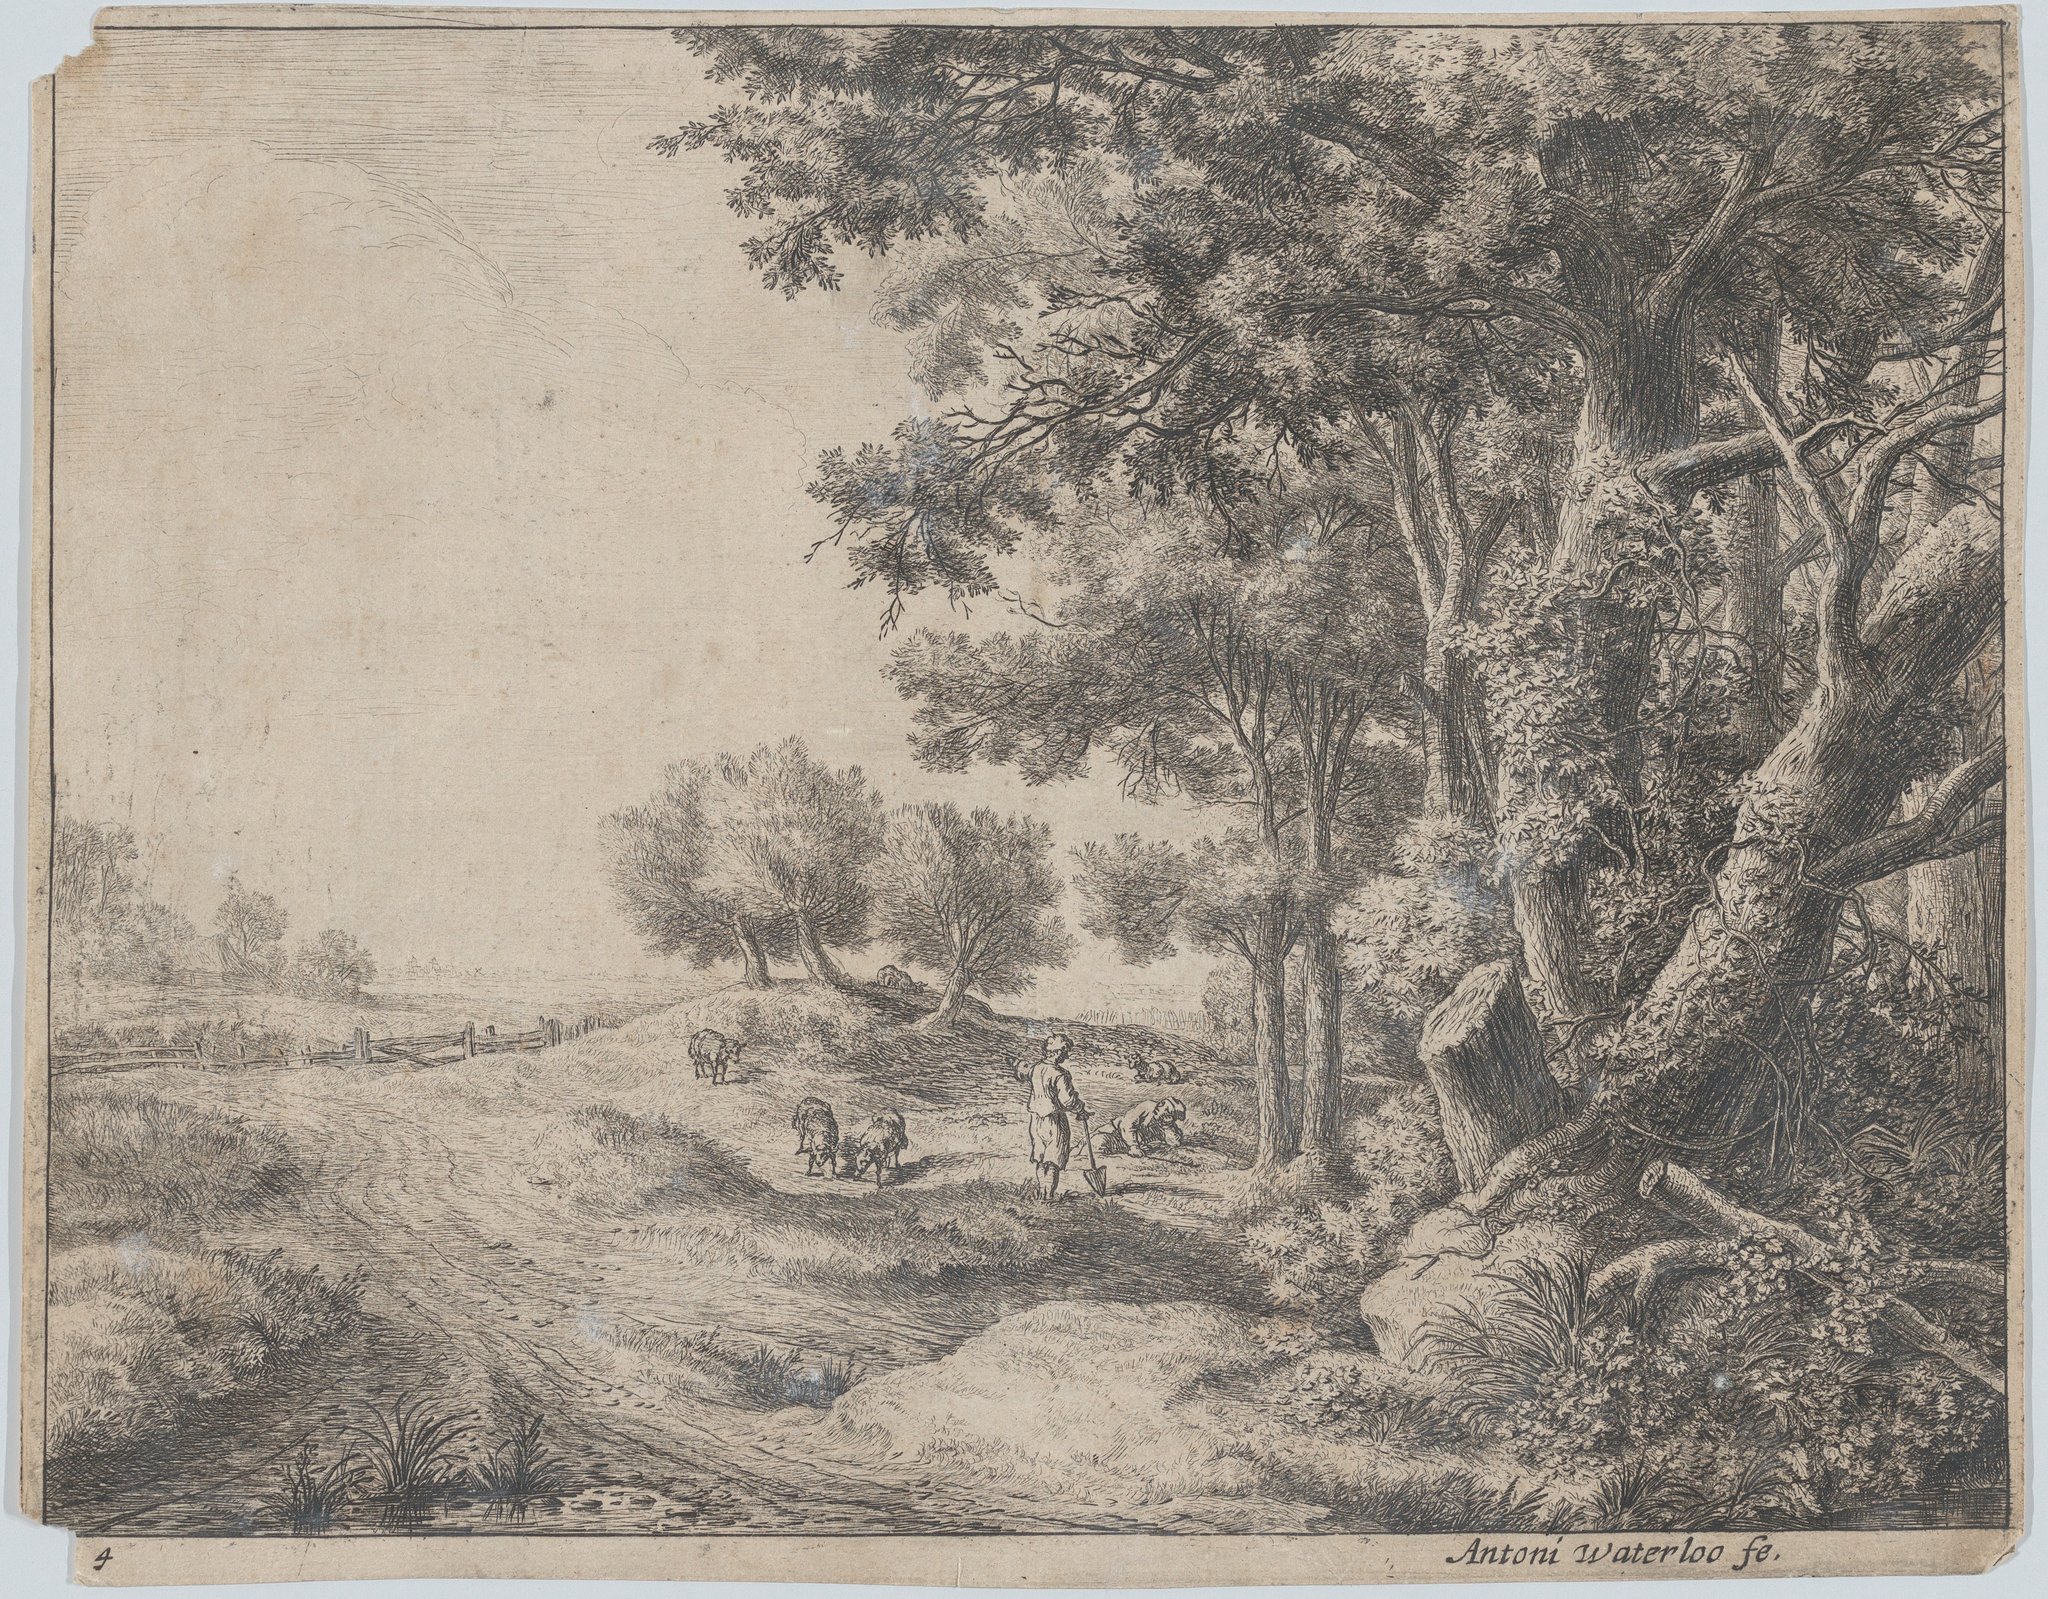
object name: print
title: A Peasant with a Shovel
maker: anthonie waterloo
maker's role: artist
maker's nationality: dutch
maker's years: 1609-1690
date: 1601-1700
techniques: etching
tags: cows,landscapes